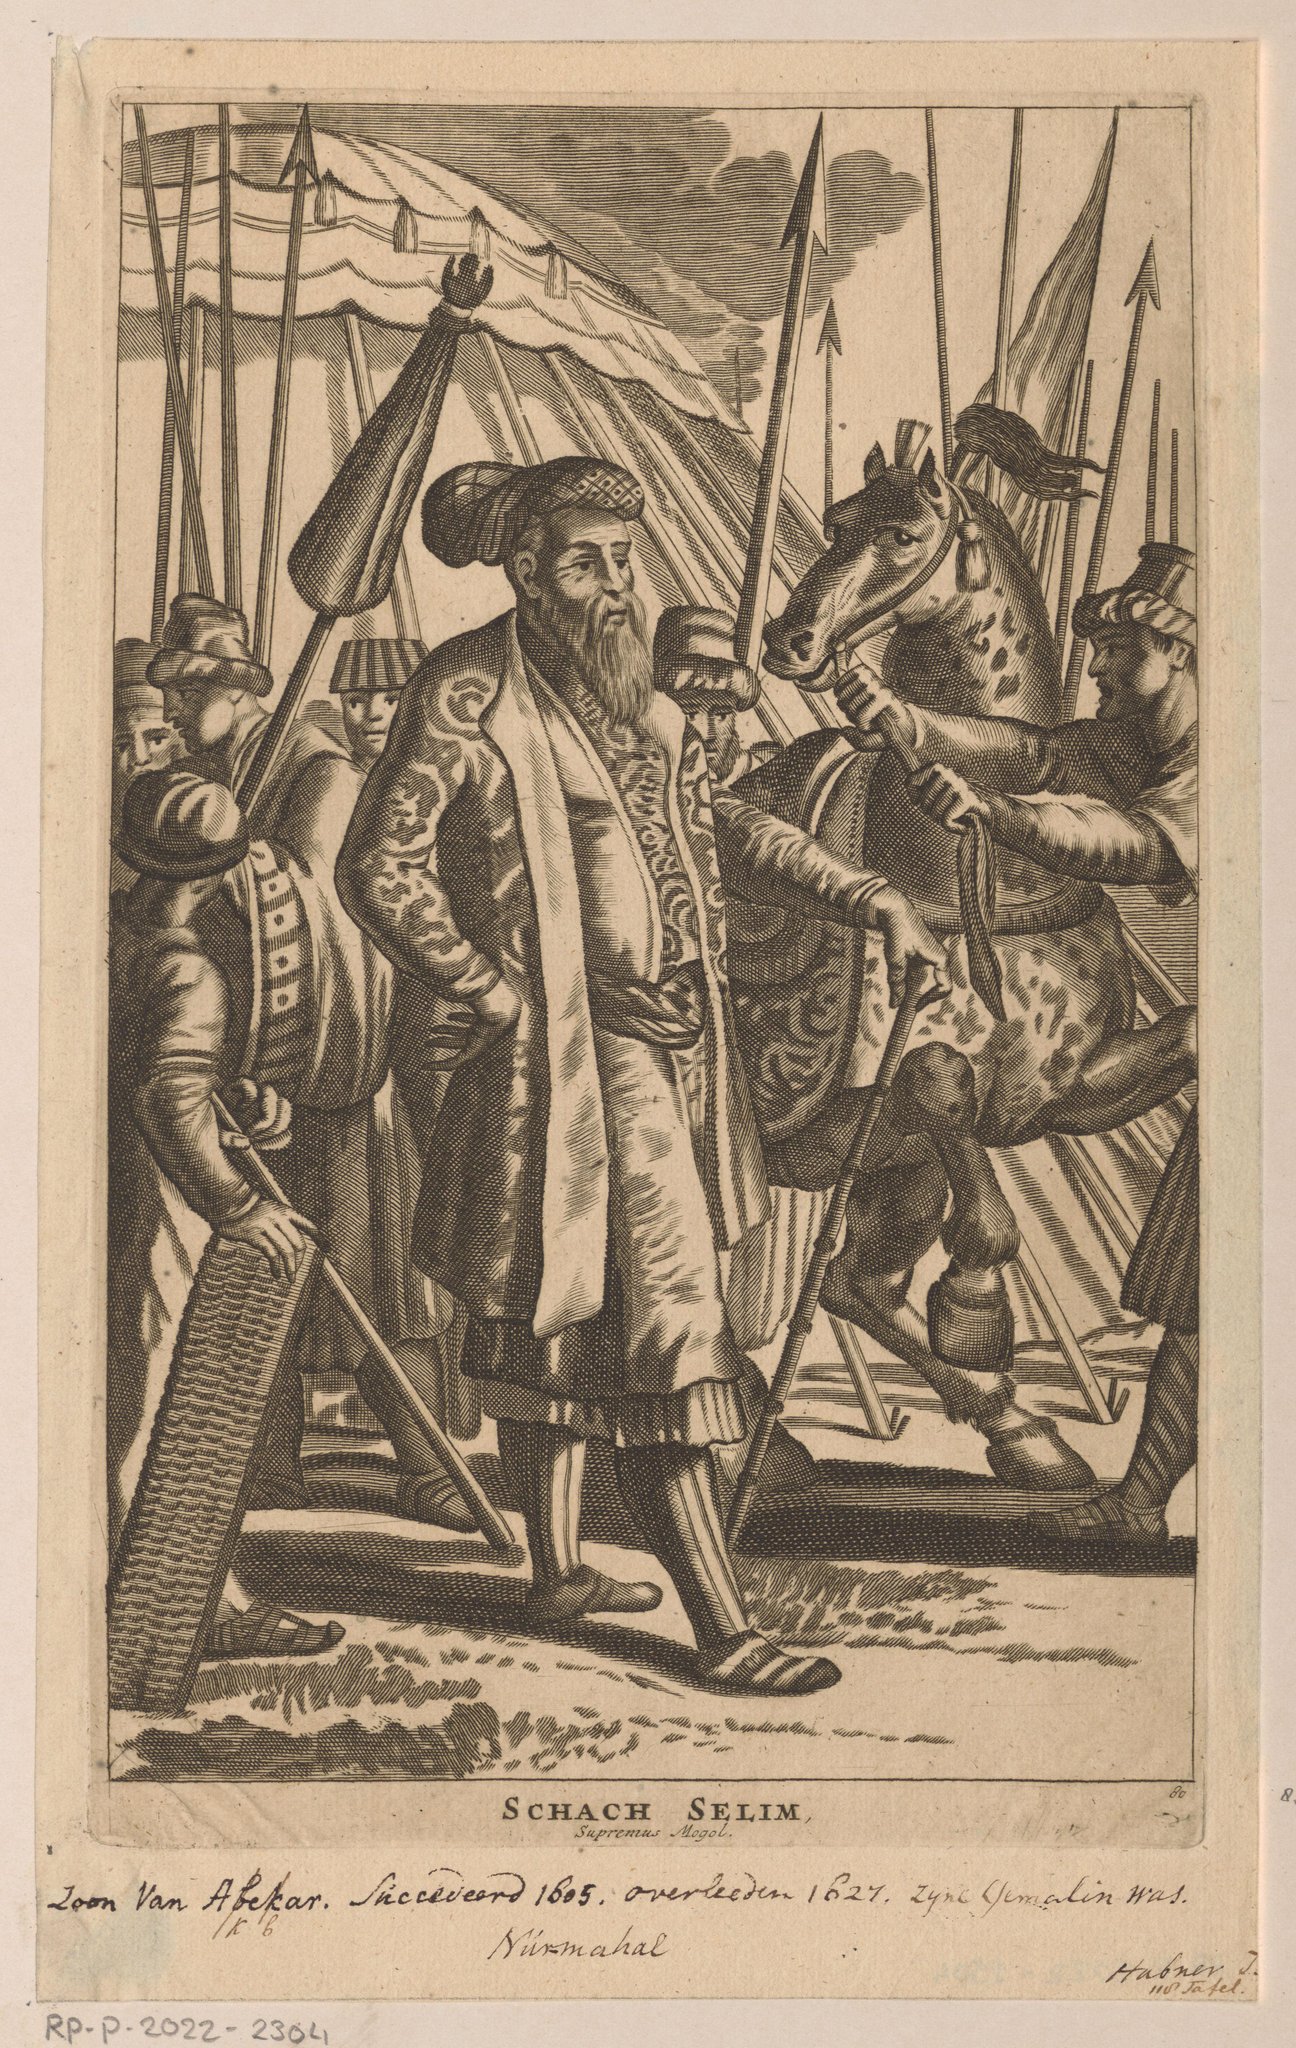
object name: print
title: Portretten van belangrijke leiders en geleerden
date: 1710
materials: paper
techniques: engraving, etching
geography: leiden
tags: historical persons, emperor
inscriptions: inscription: ‘Zoon van Abekar. Succedeerd 1605. overleeden 1627 zijne gemalin was / Nürmahal / Hubner J. / 118 Tafel.’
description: Prent uit de serie: Principum et illustrium quorundam virorum qui in Europa alibique terrarum quam fama quam eruditione celebres fuerunt, verae imagines. Leiden: Pieter van der Aa, [ca. 1710].